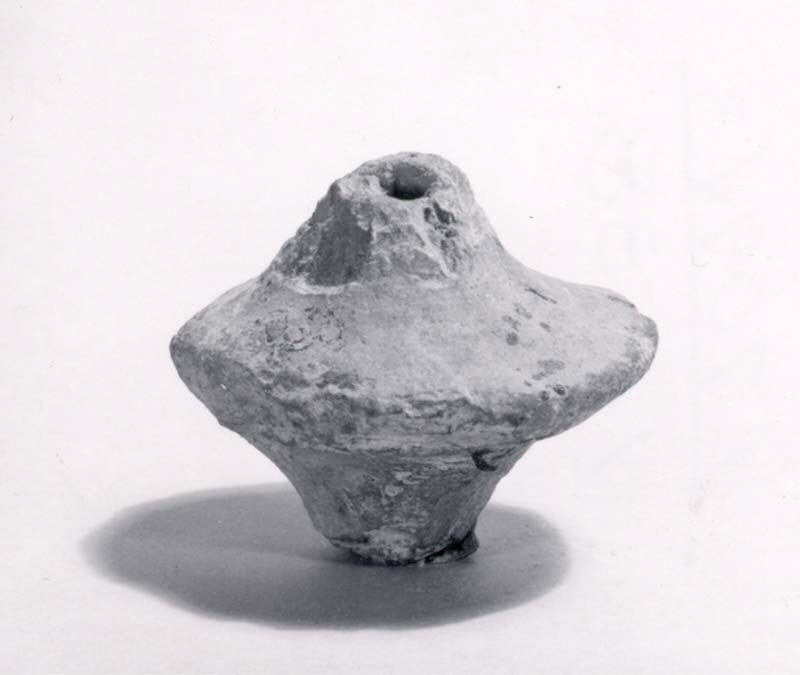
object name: whorl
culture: iranian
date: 900-801 BCE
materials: ceramic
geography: iran